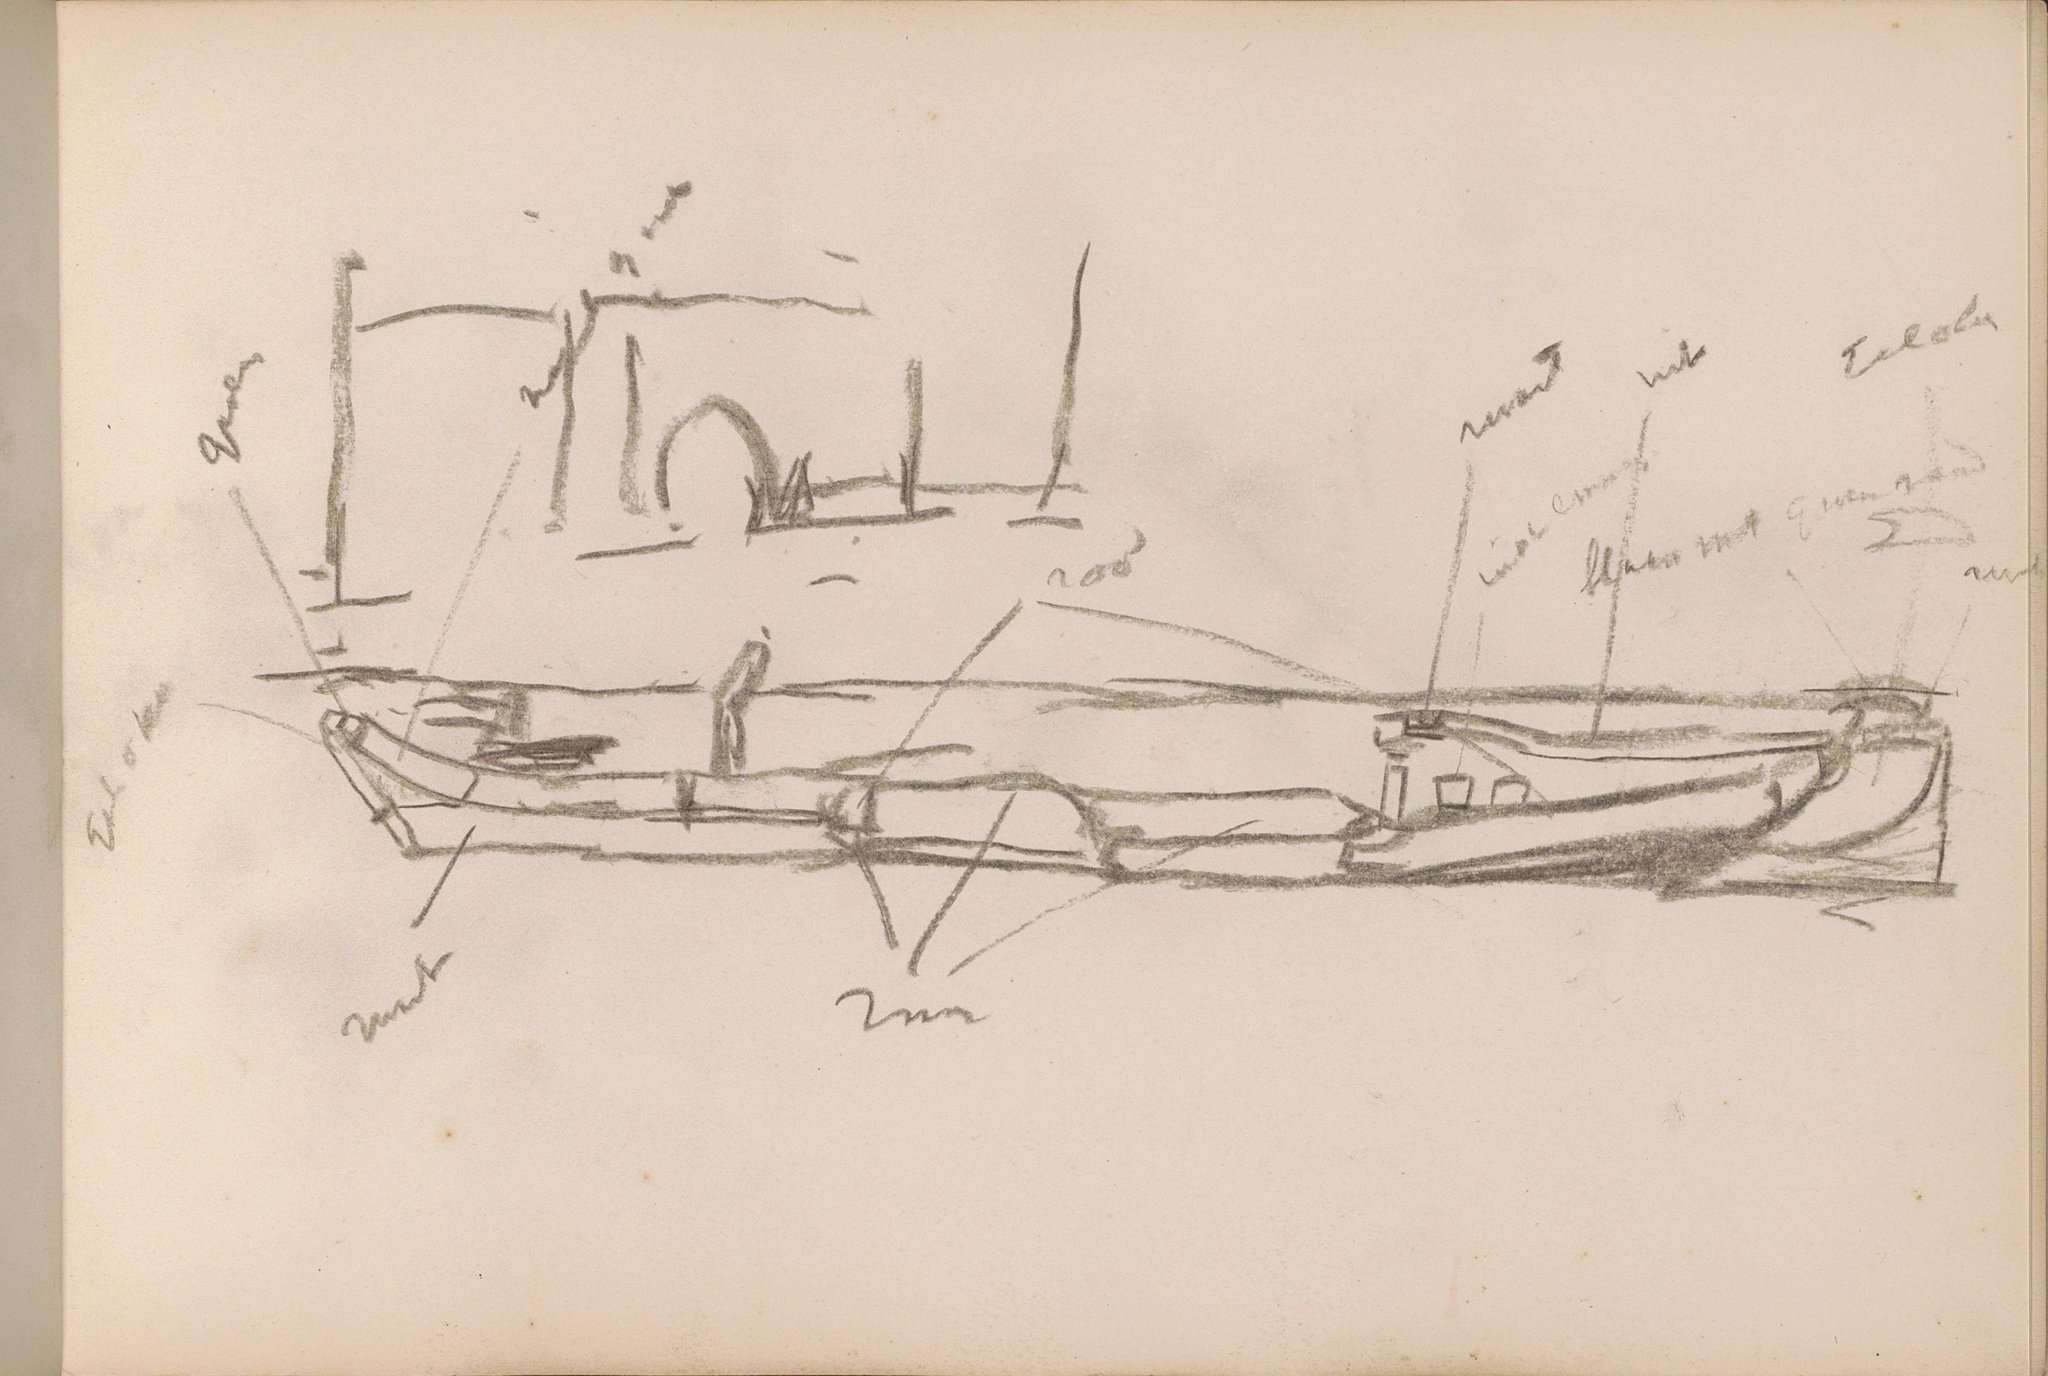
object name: sketchbook leaf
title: Eén of twee aangemeerde schuiten, mogelijk bij de Nieuwe Teertuinen te Amsterdam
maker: george hendrik breitner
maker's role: draughtsman, painter, print maker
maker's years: 1857-1923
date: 1898-1914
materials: chalk, paper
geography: amsterdam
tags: adult man, ships (in general), civic architecture; edifices; dwellings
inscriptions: kleurnotitie, handgeschreven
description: Pagina 32 uit een schetsboek met 21 bladen.